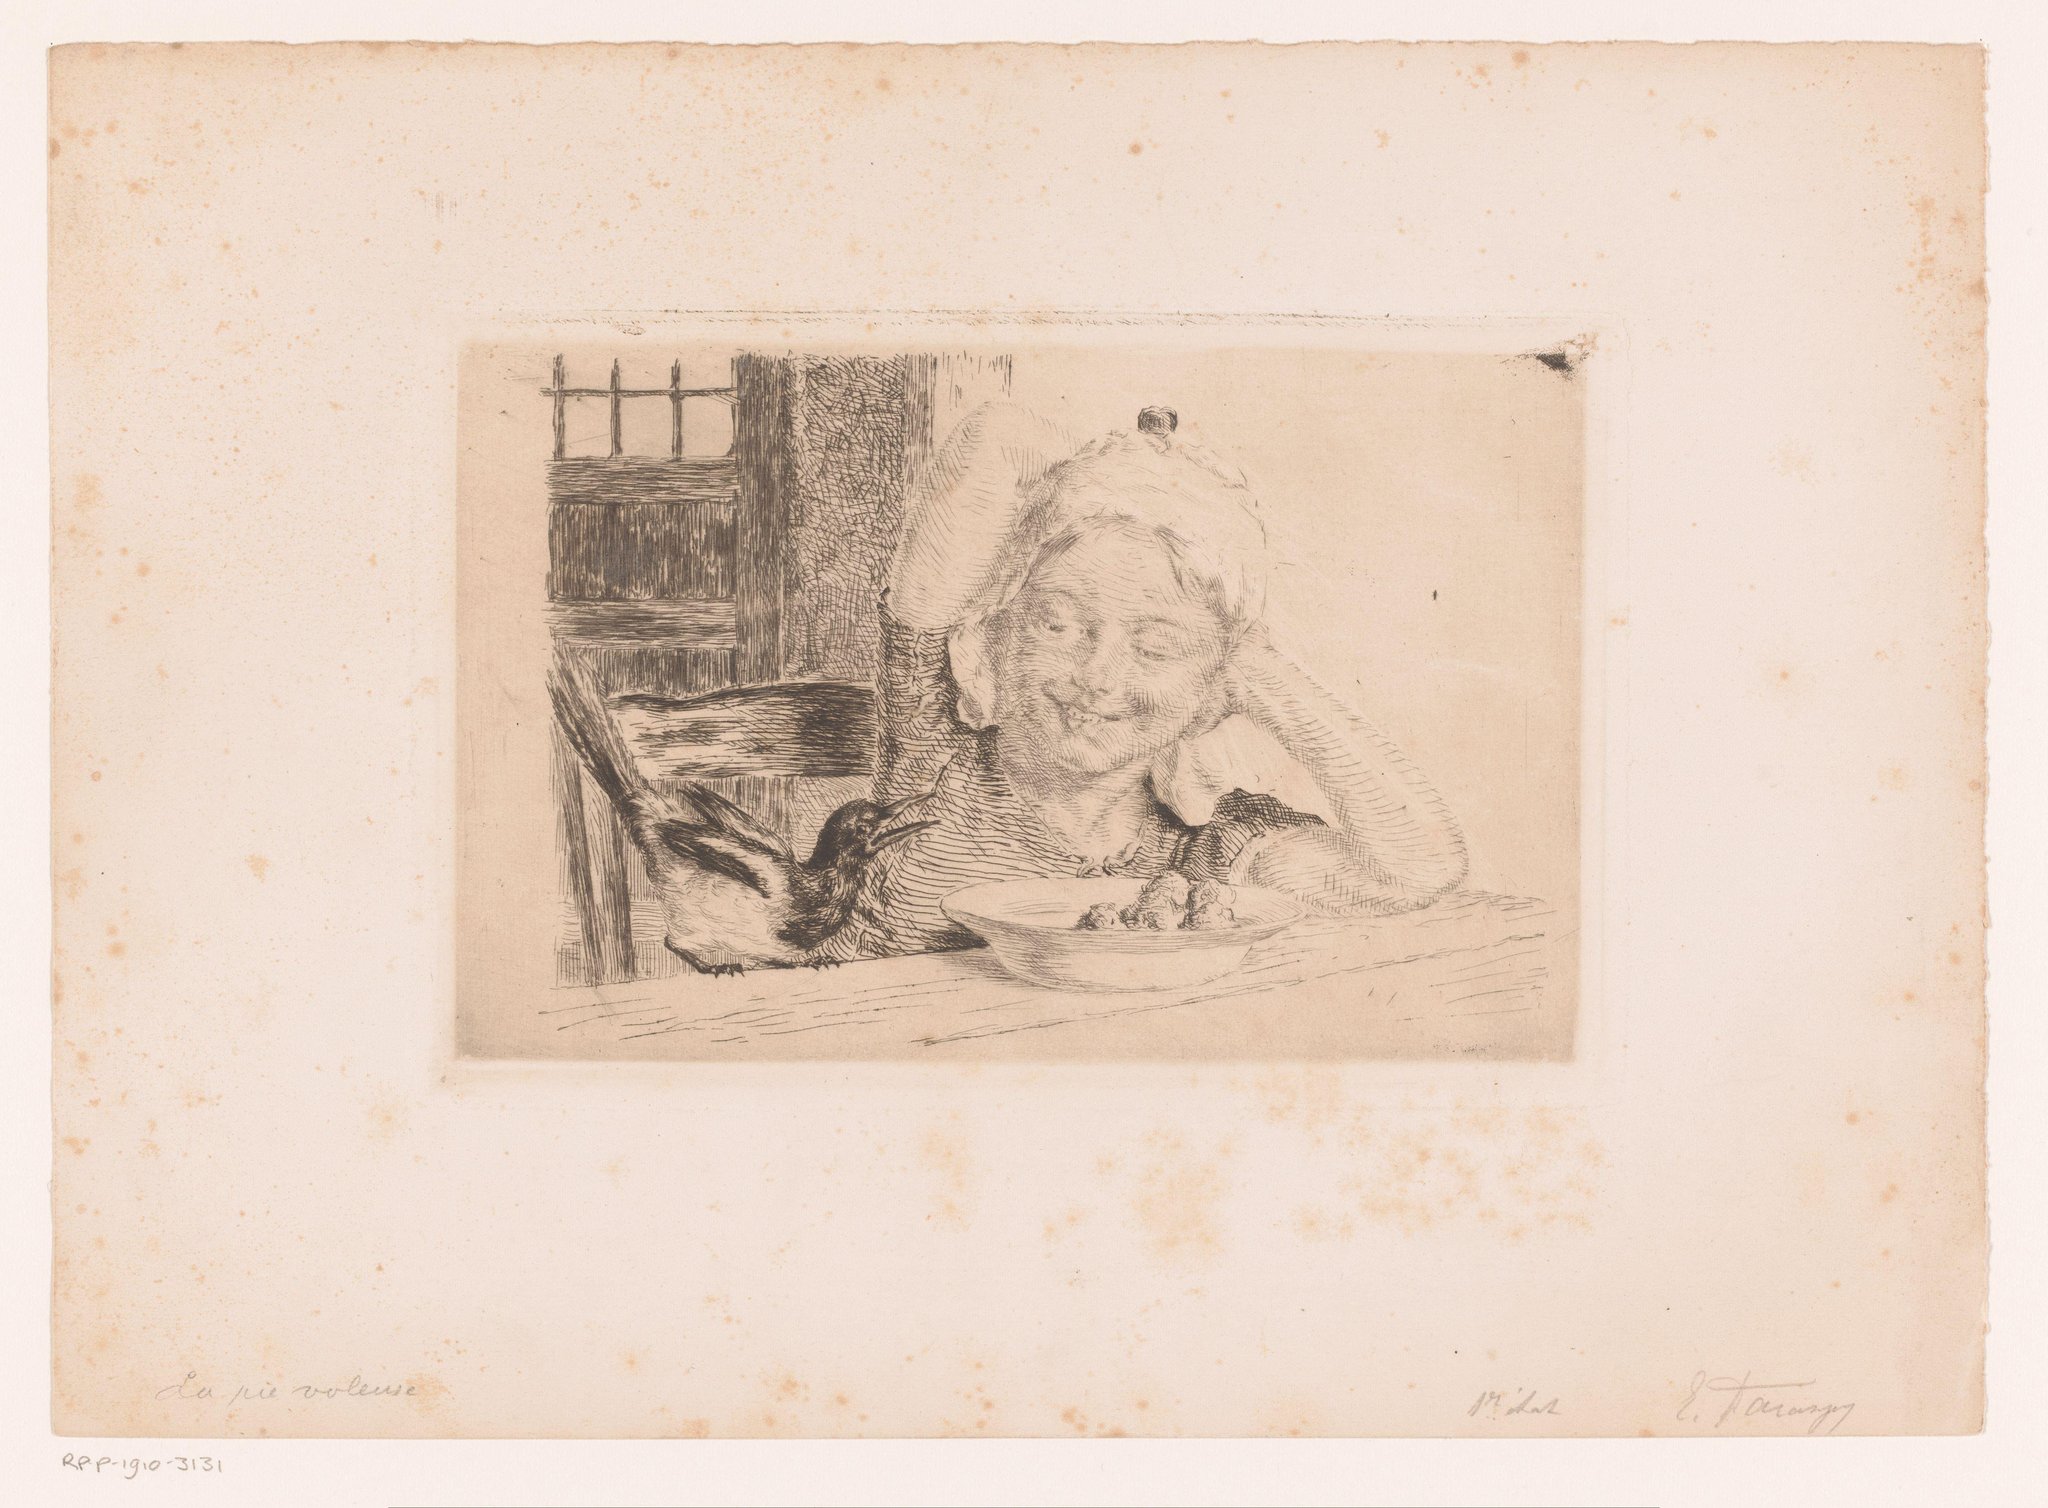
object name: print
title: Meisje aan een tafel met een bord eten en een ekster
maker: edgard farasyn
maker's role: print maker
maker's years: 1858-1938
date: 1868-1911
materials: paper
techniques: etching, intaglio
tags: girl (child between toddler and youth), dish, plate, saucer, song-birds: magpie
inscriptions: collector's mark: Lugt 2228, inscription: ‘La pie voleuse; 1e état’